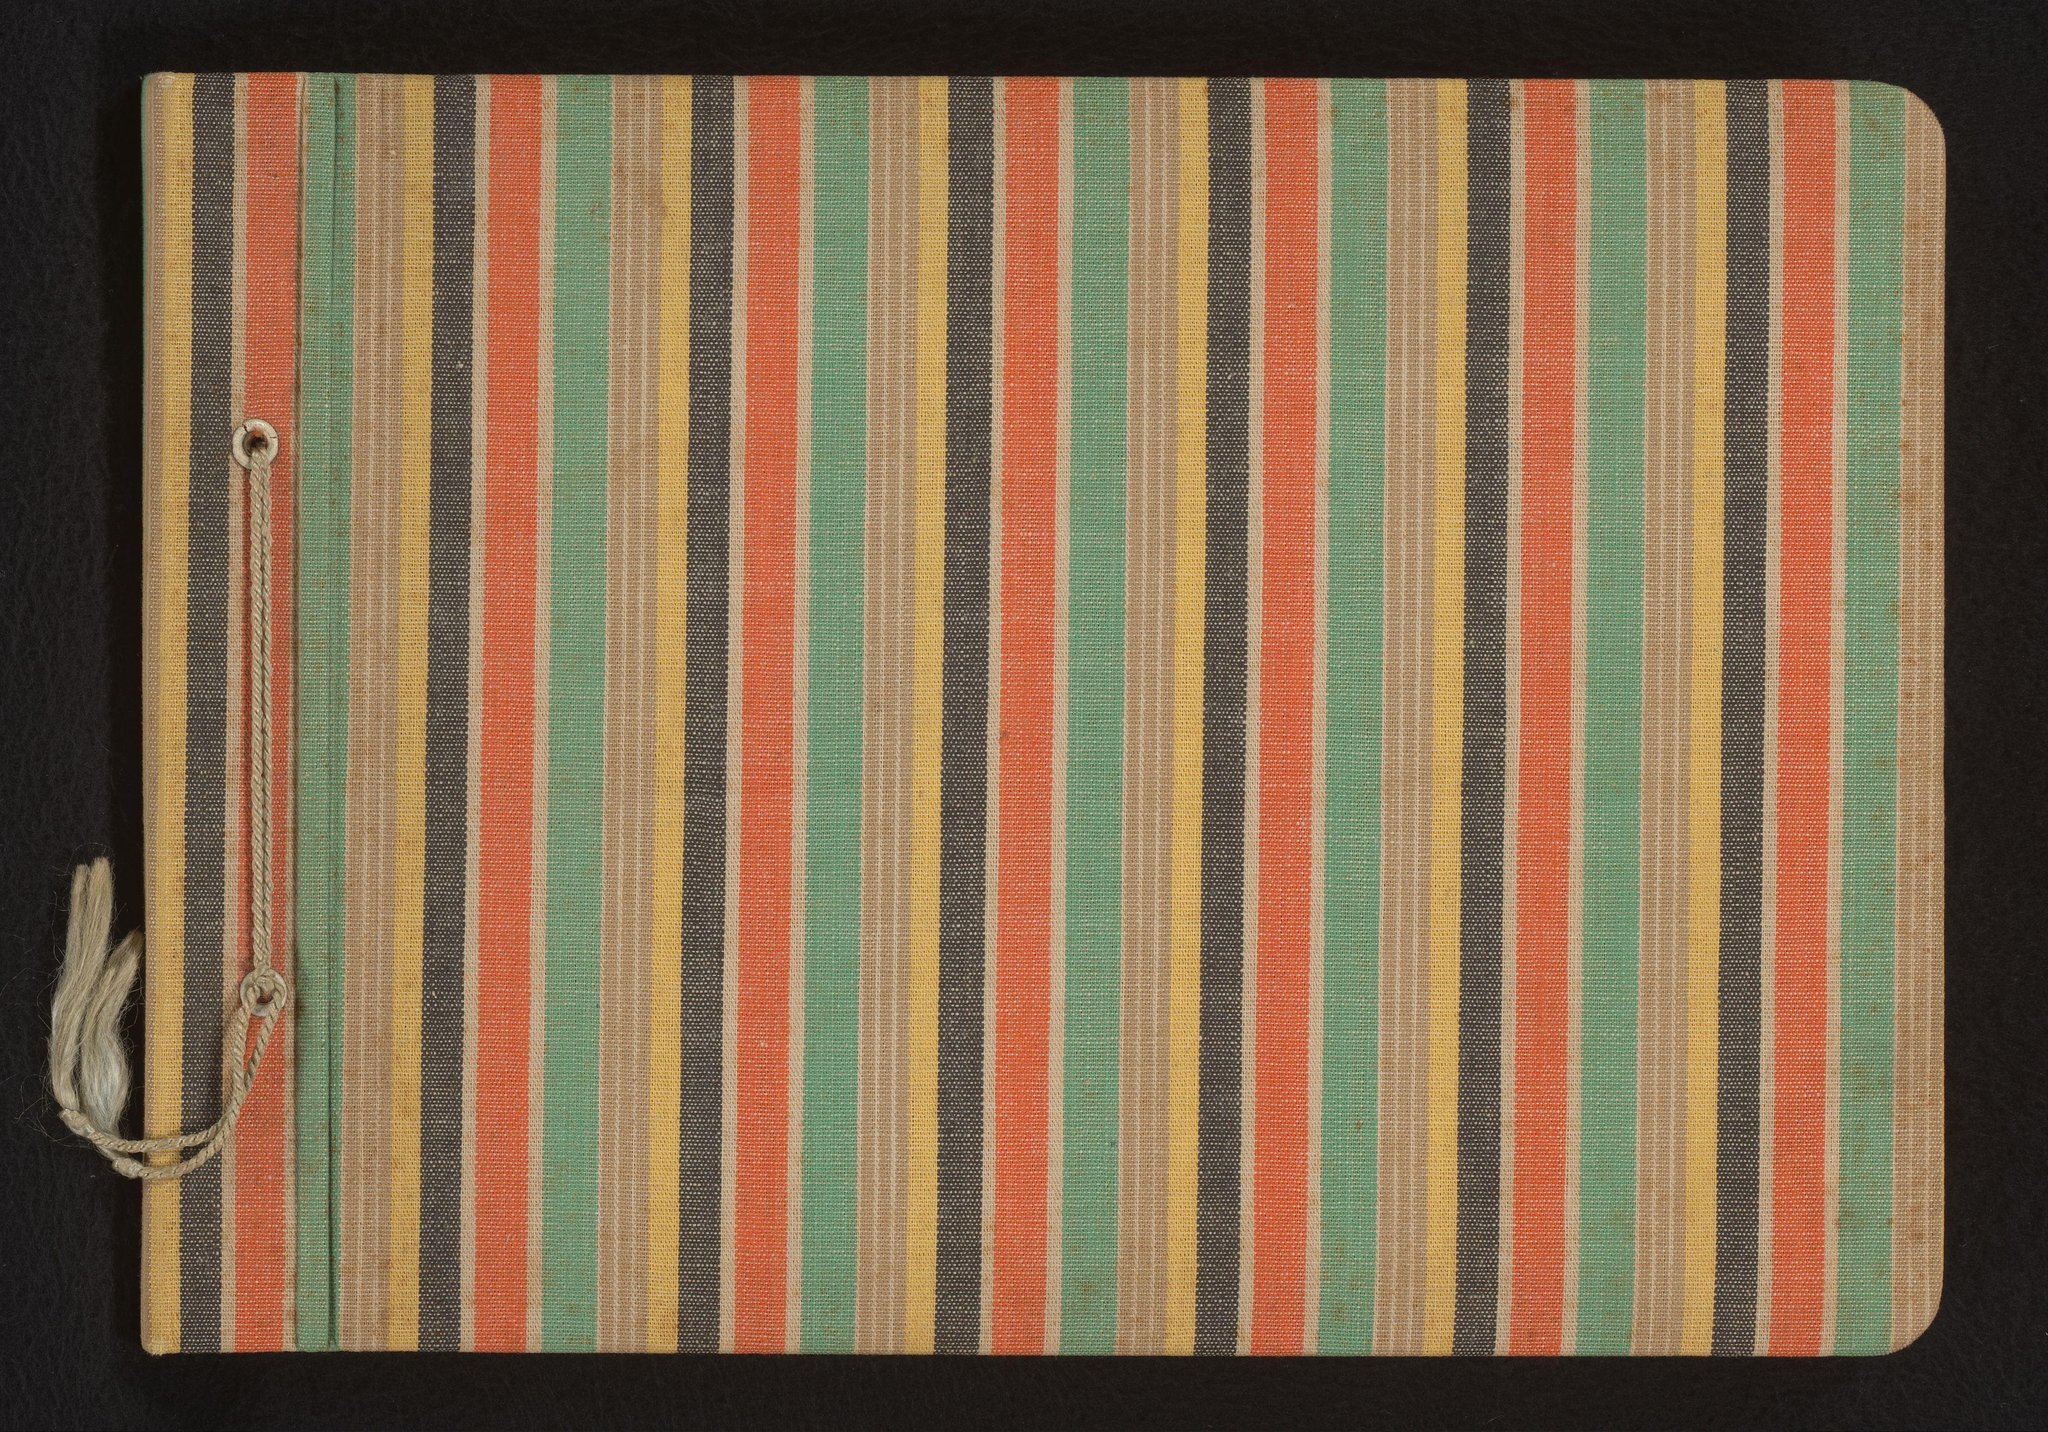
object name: photograph album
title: Vakantiealbum van een reis langs de Nijl, 1936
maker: Anonymous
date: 1936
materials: paper, photographic support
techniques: gelatin silver print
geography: egypt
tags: tourism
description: Fotoalbum met een verticaal gestreept gekleurd stoffen omslag. Hierin 20 crèmekleurige binnenbladen met een groen koord in omslag gebonden. Het album bevat 84 zwart-wit foto's van een vakantie in 1936 langs de Nijl in Egypte aan boord van het schip 'Princesa Olga', beginnend in Athene en Split. Foto's van o.a. de Sphinx, Caïro, Piramide van Cheops, Luxor, beelden van Ramses II, het dal der koningen, in Thebe de Deir El Bahari-tempel, tombe van Toetanchamon, de kolossen van Memnon, Karnak, een stuwdam, een berberdorp, Philae enz. 12 Foto's ontbreken. Foto's voorzien van bijschrift.